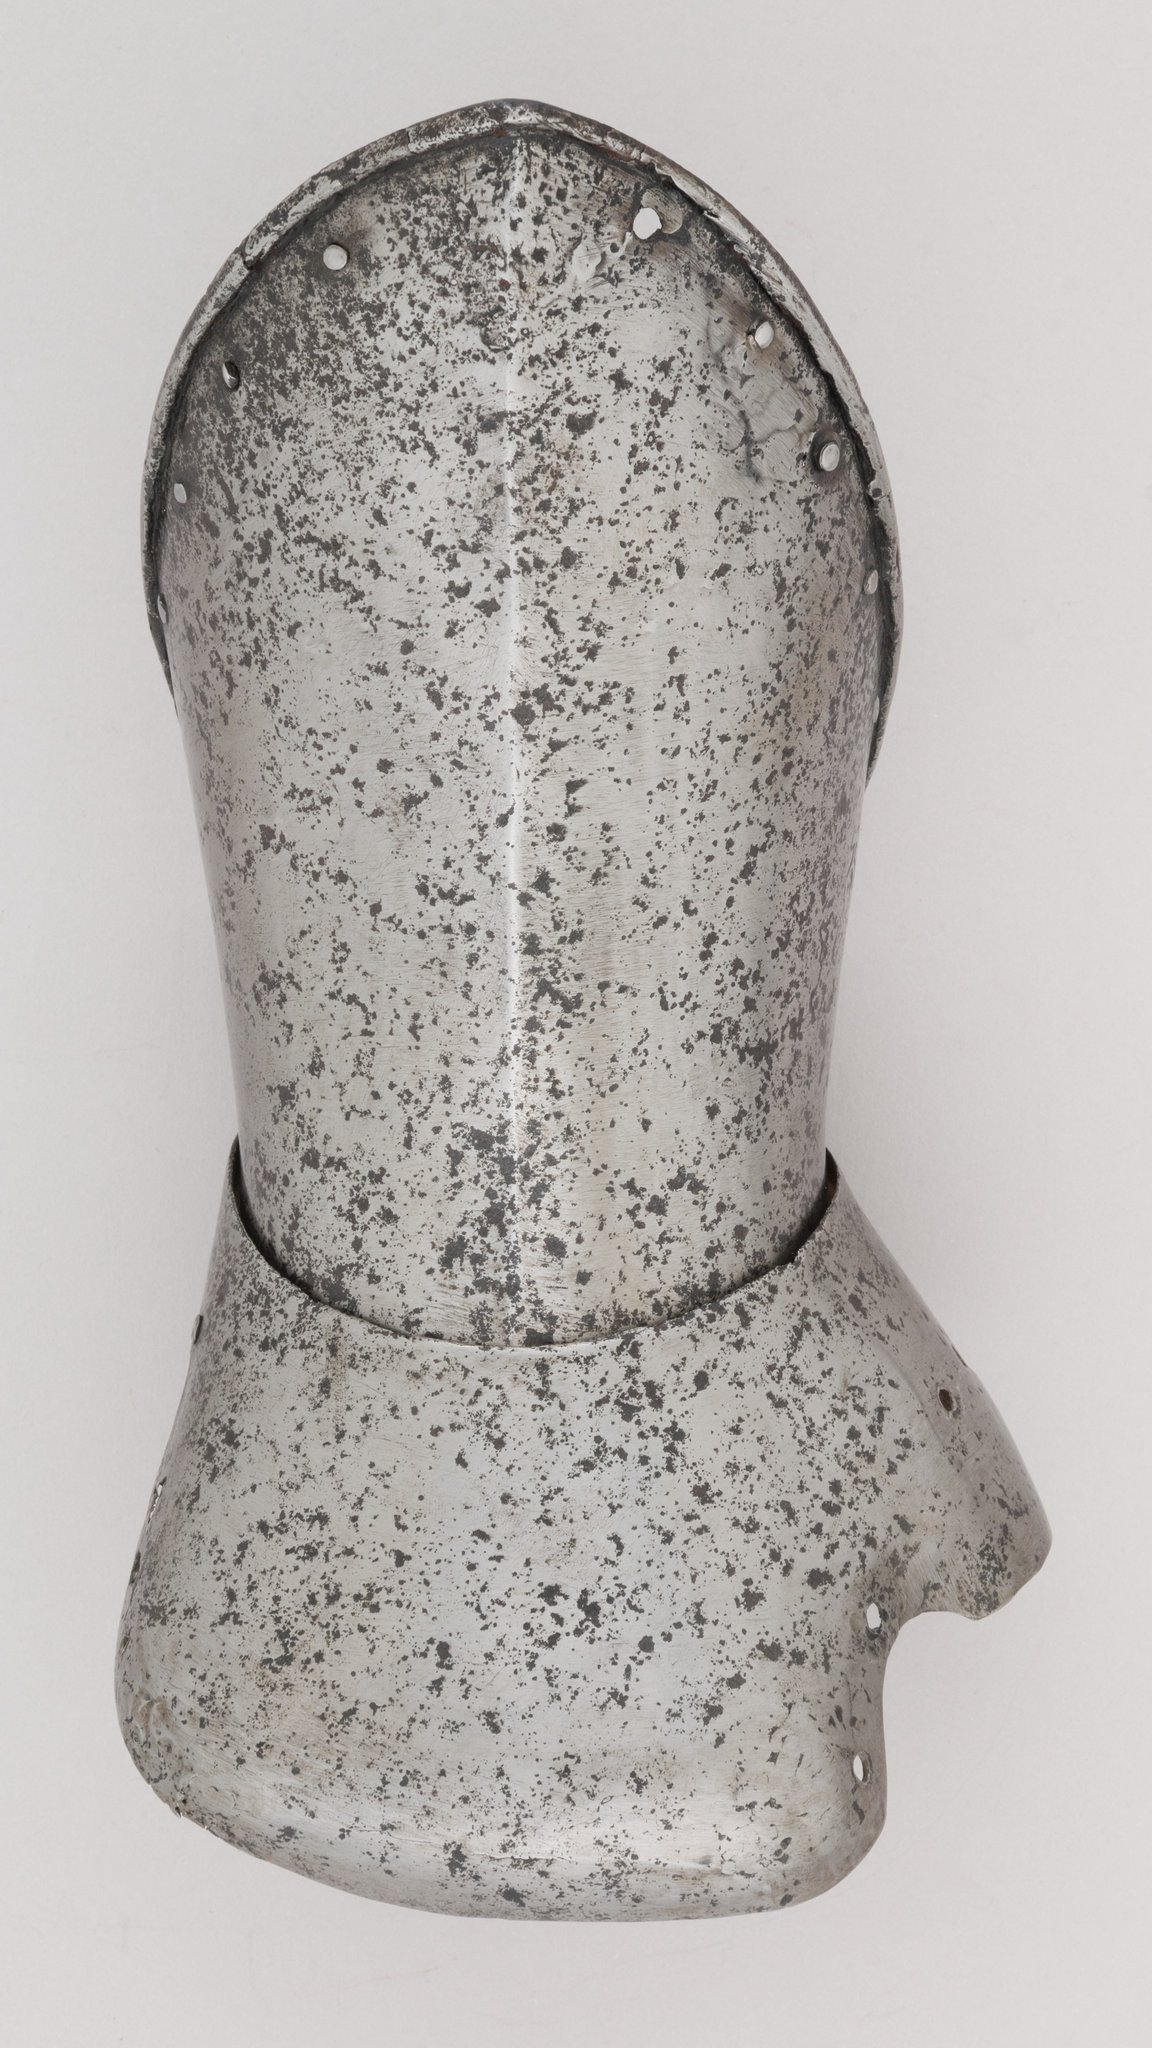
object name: gauntlet for the right hand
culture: italian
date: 1450-1460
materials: steel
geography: italy